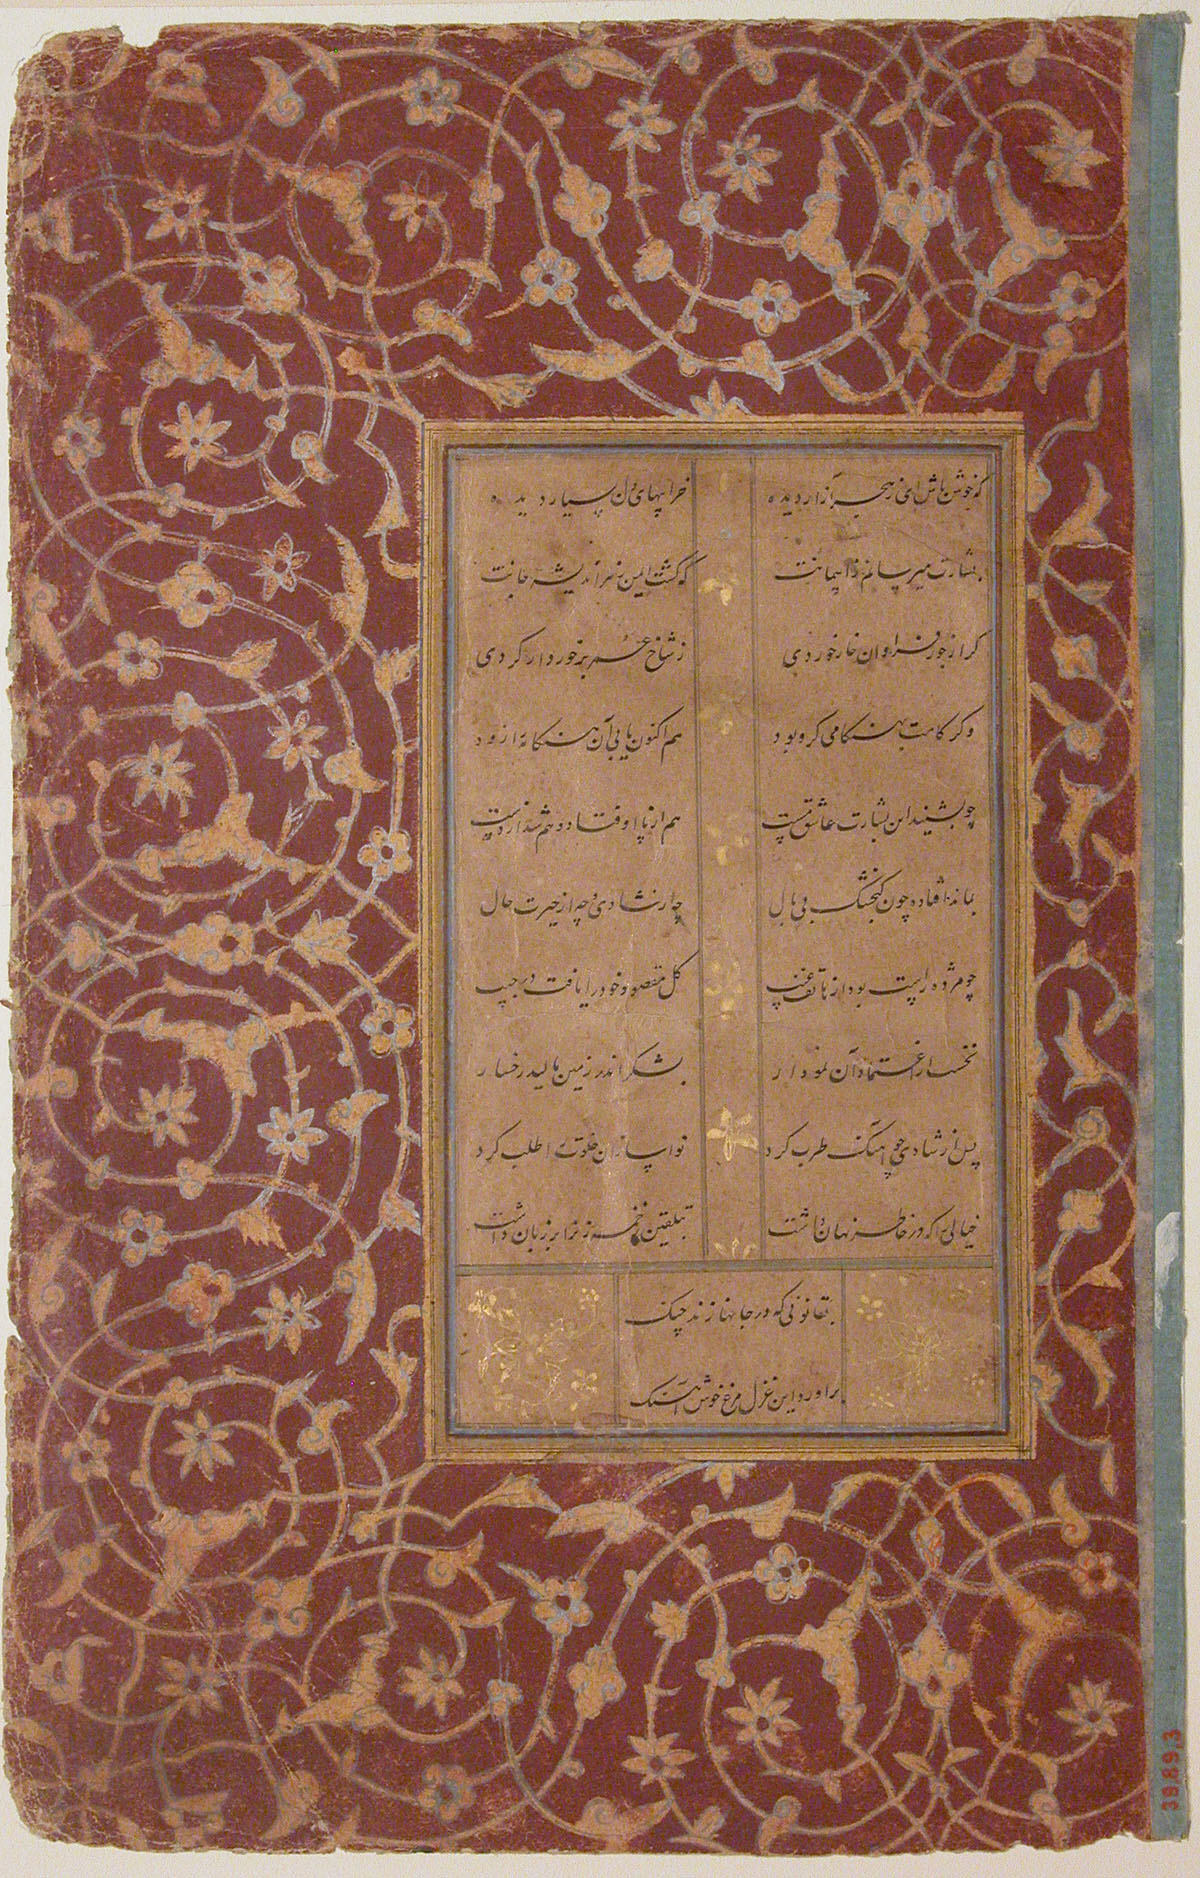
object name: folio from an illustrated manuscript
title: "Sonnet from a Lover to the Beloved", Folio from a Manuscript of Poetry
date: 1501-1533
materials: gold, ink, paper, silver, watercolor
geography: iran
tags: poetry